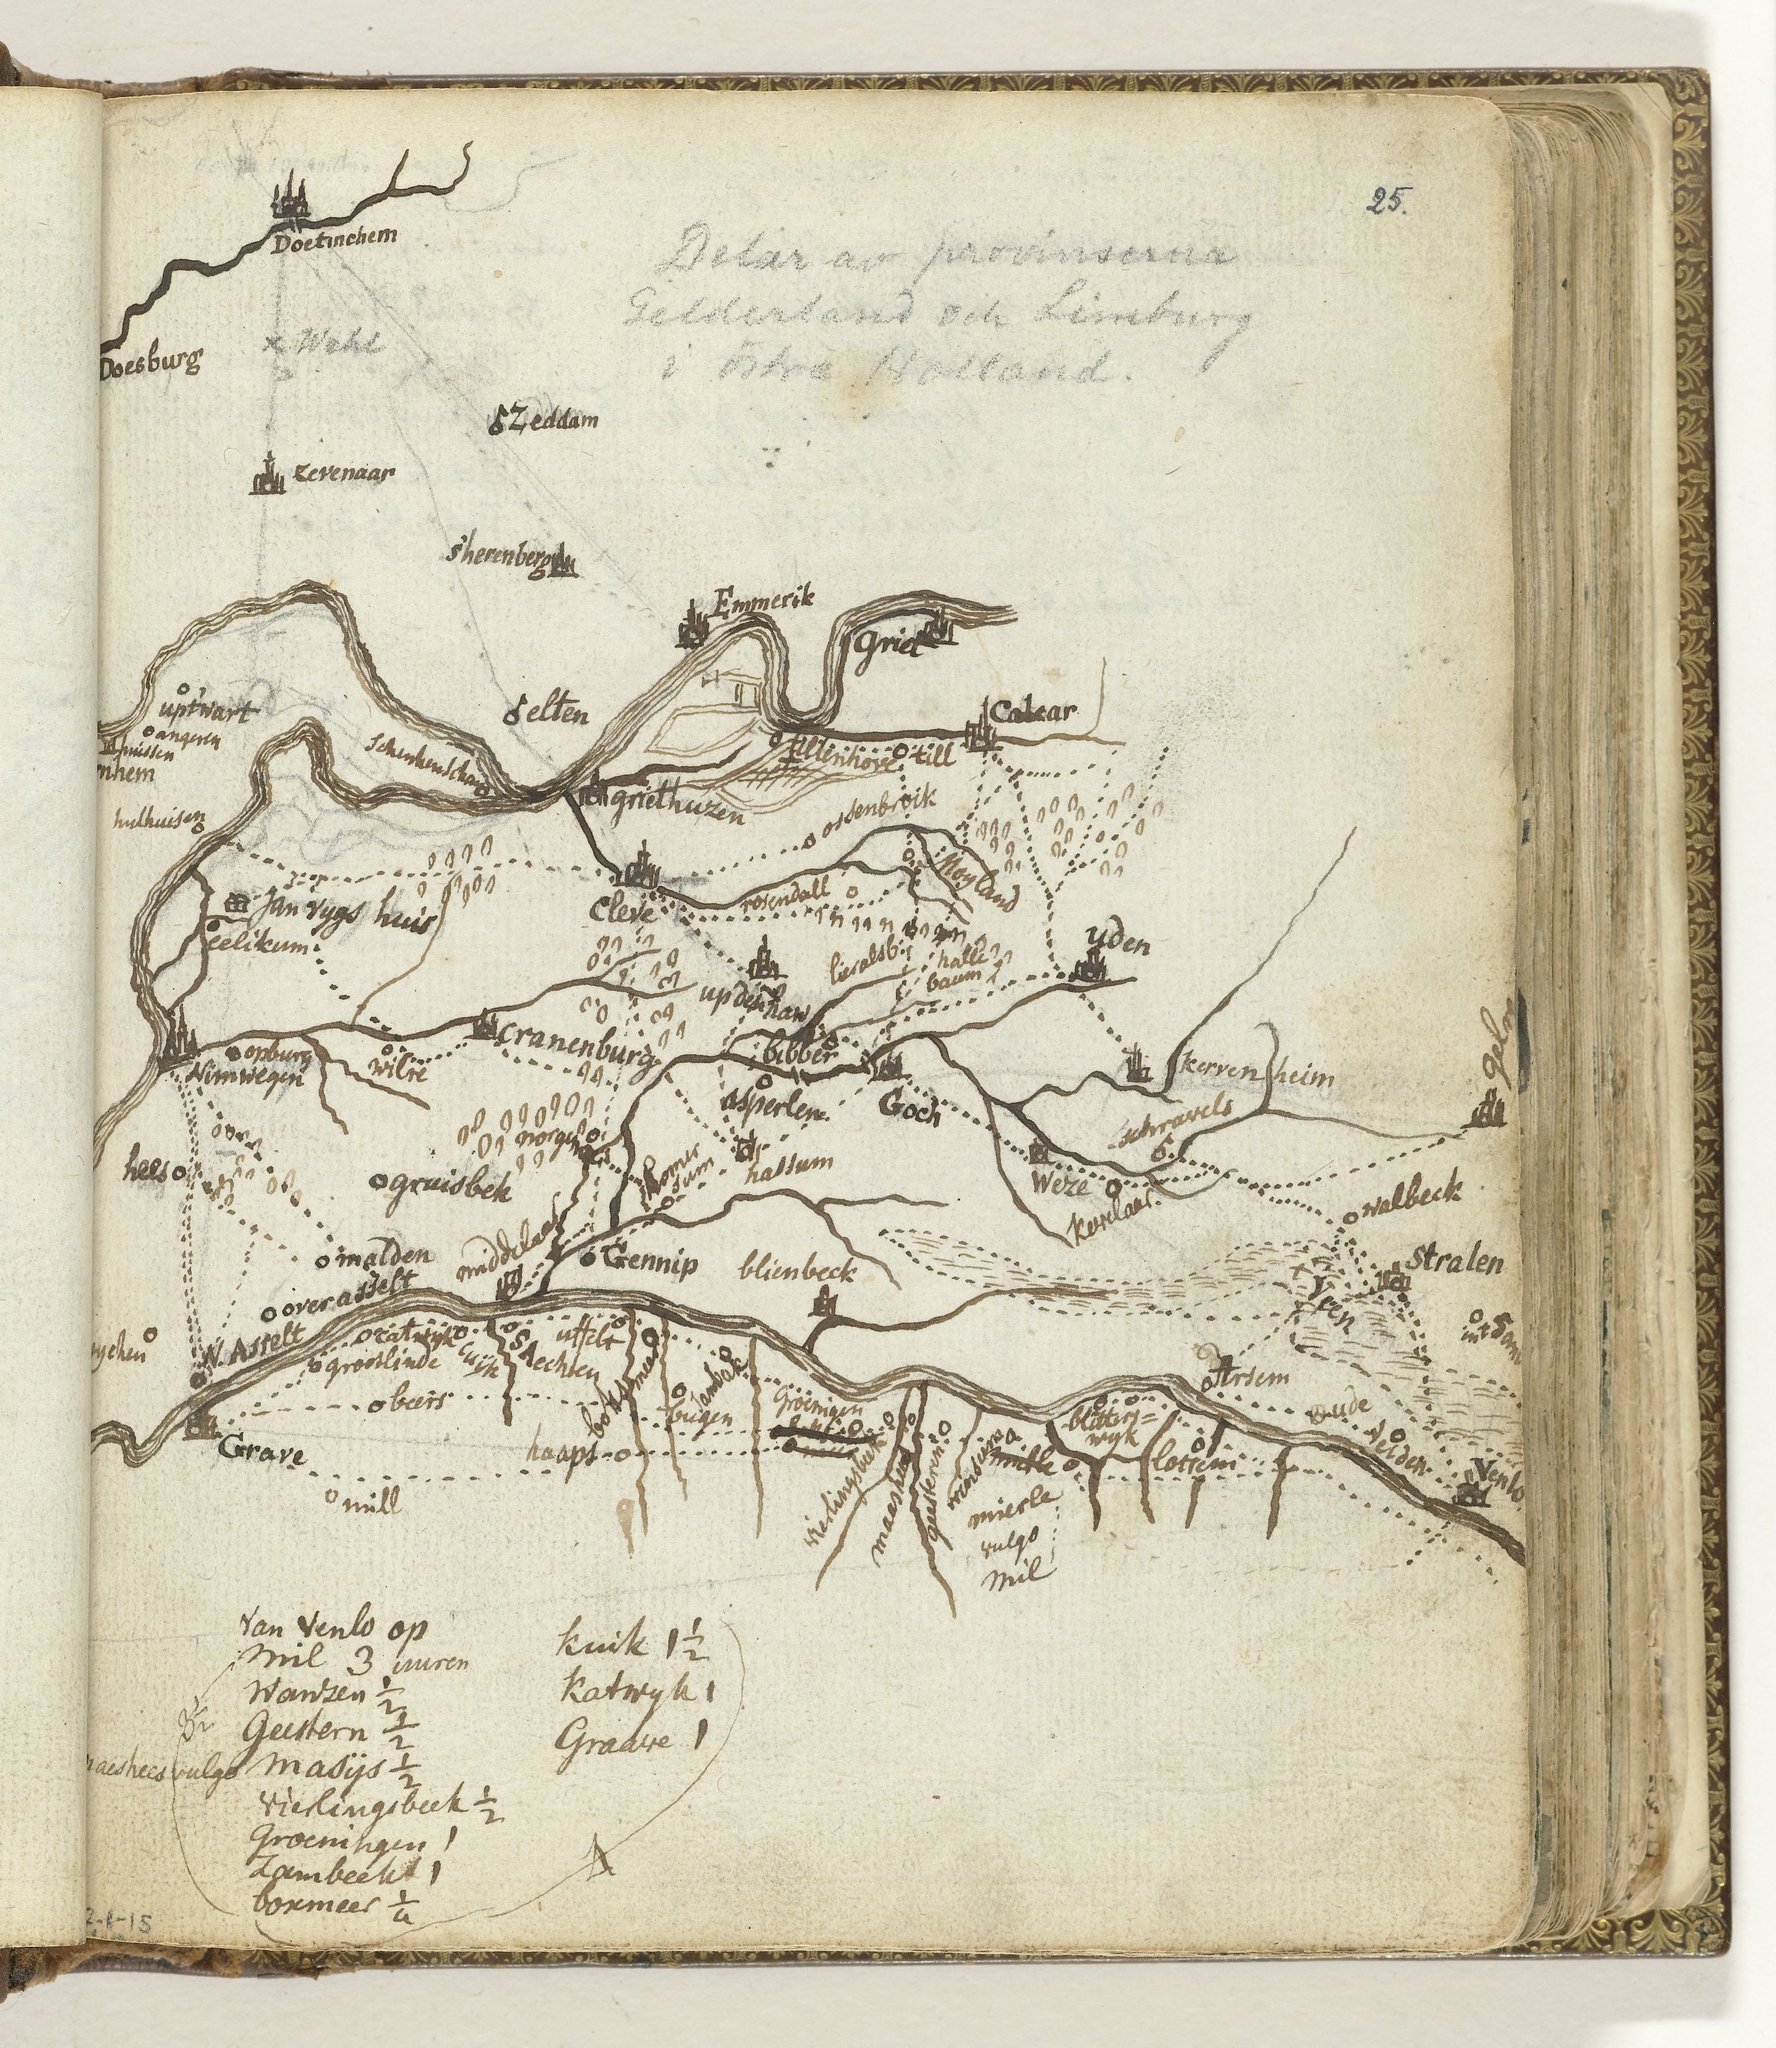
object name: drawing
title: Kaart van de streek tussen Doetinchem en Venlo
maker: jan brandes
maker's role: draughtsman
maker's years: 1743-1808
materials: ink, paper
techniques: pen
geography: gelderland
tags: maps of separate countries or regions, gelderland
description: Penteking van kaart met opschrift van steden, dorpen, rivieren met vermelding van reistijd. Onderdeel uit het schetsboek van Jan Brandes, dl. 1 (1808), p. 25.